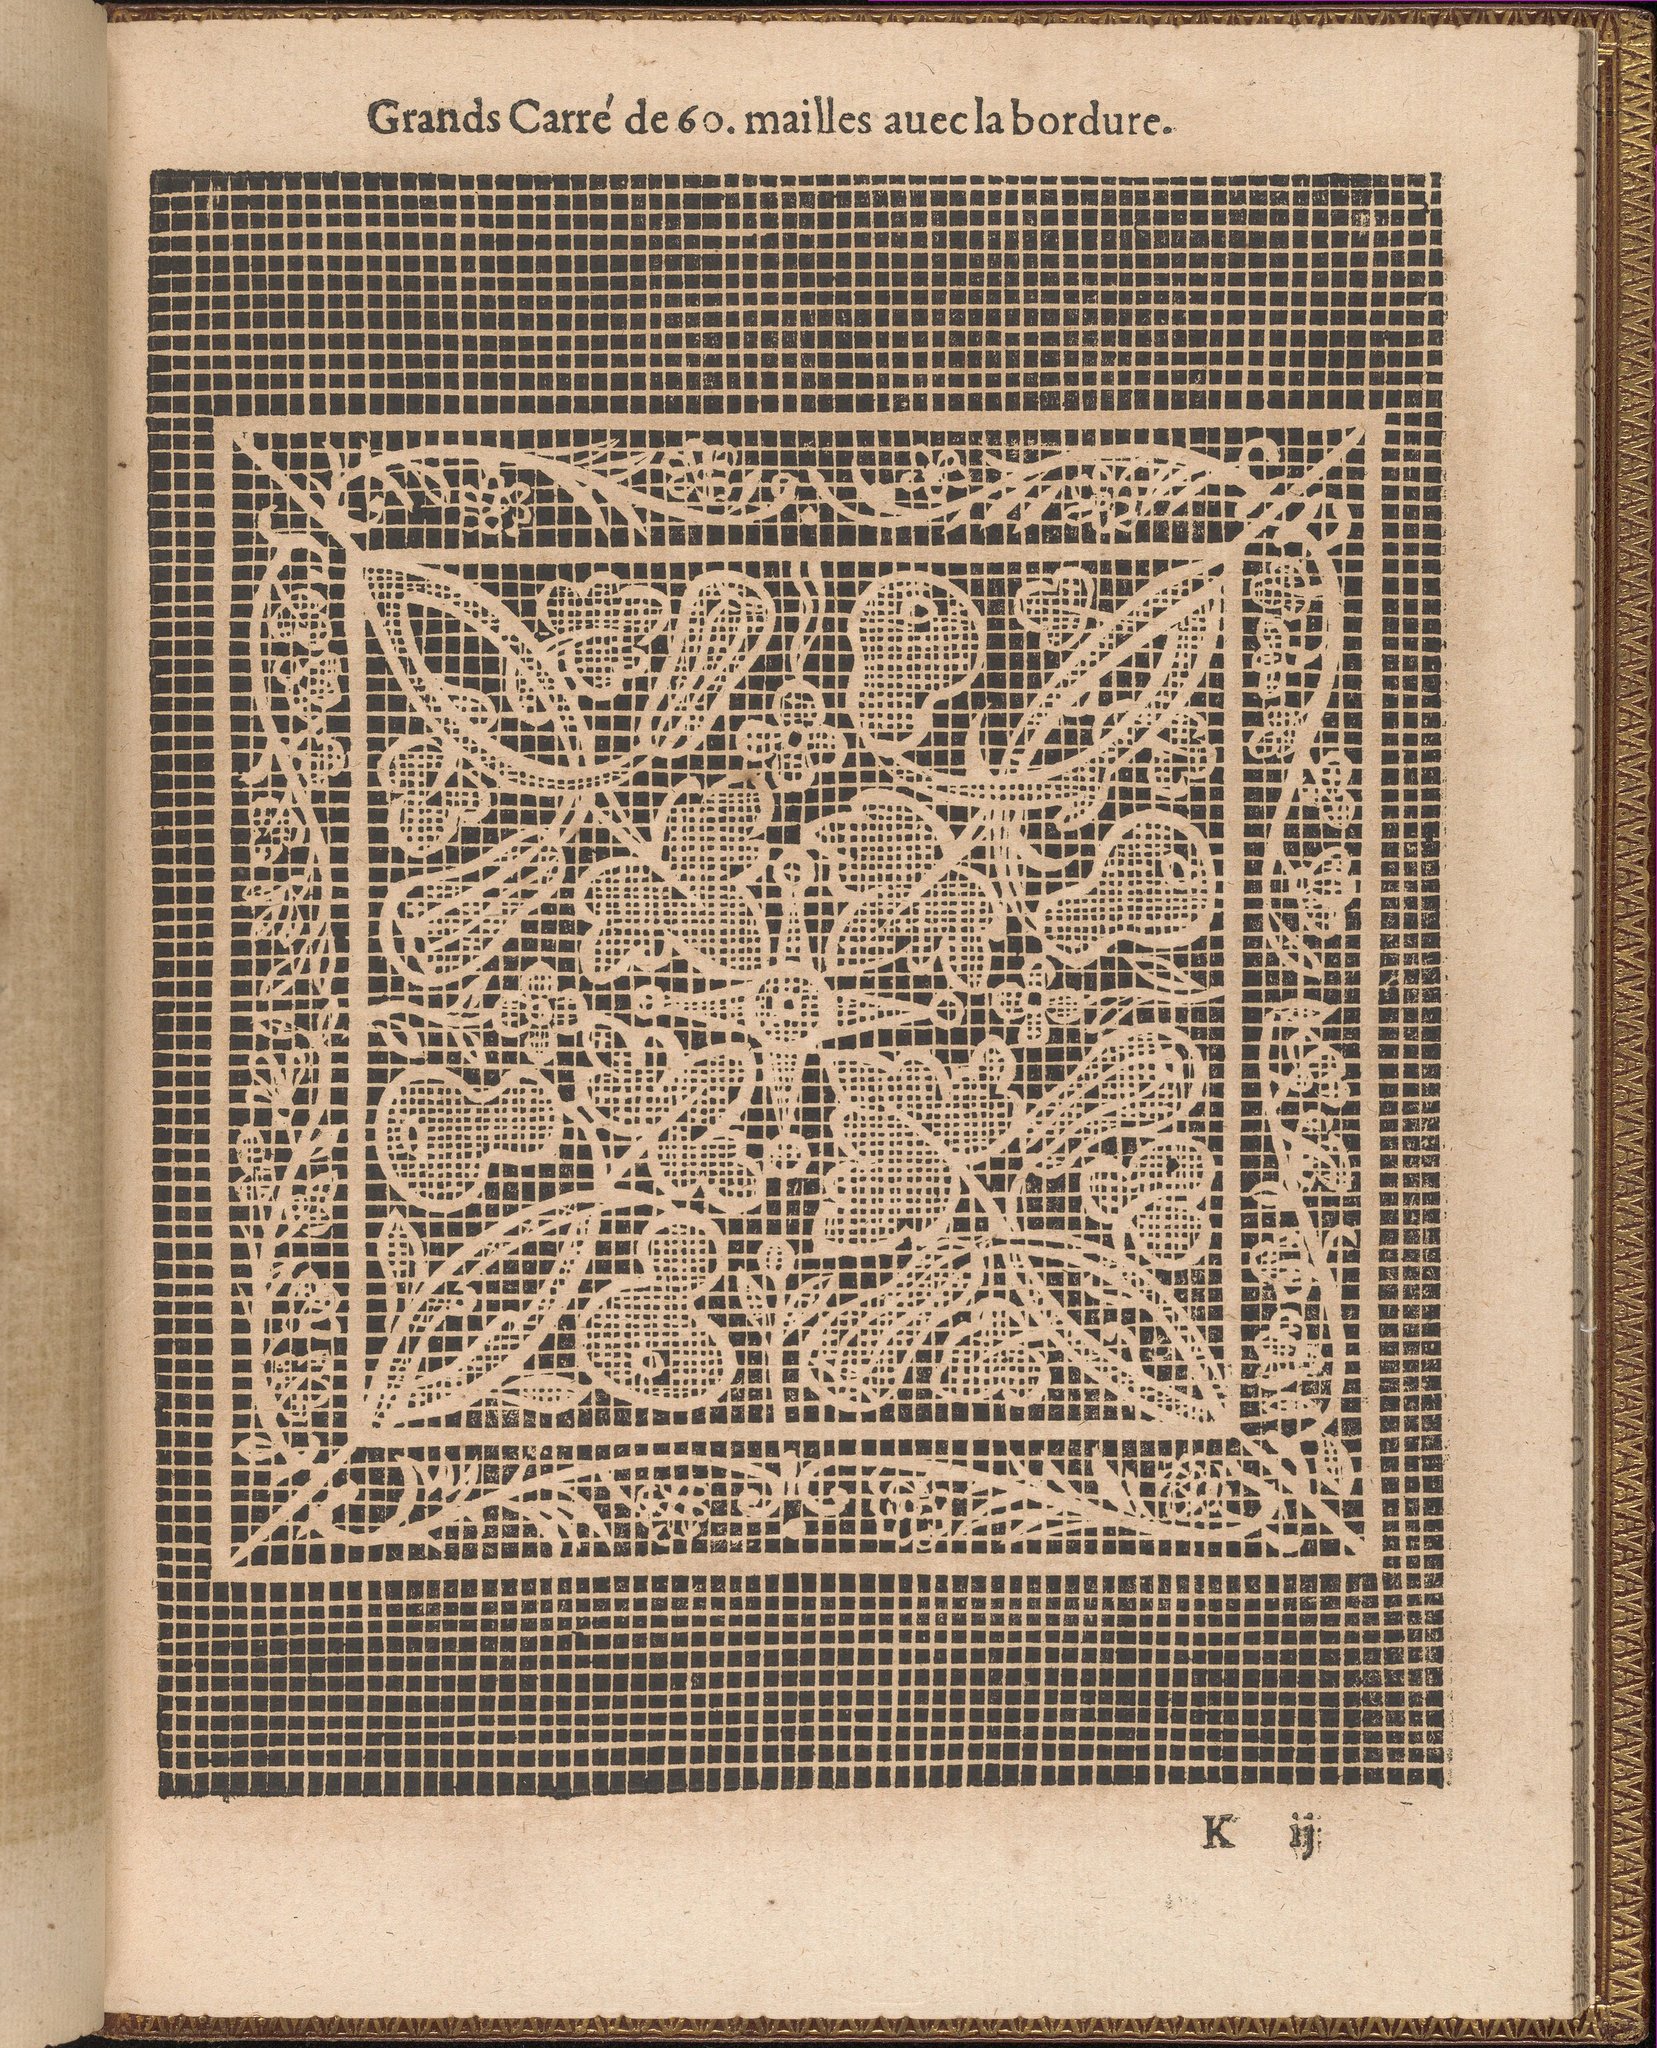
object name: book print ornament architecture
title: La Pratique de l'Aiguille, page 37 (recto)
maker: matthias mignerak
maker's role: author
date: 1605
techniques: woodcut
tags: fruit,stars